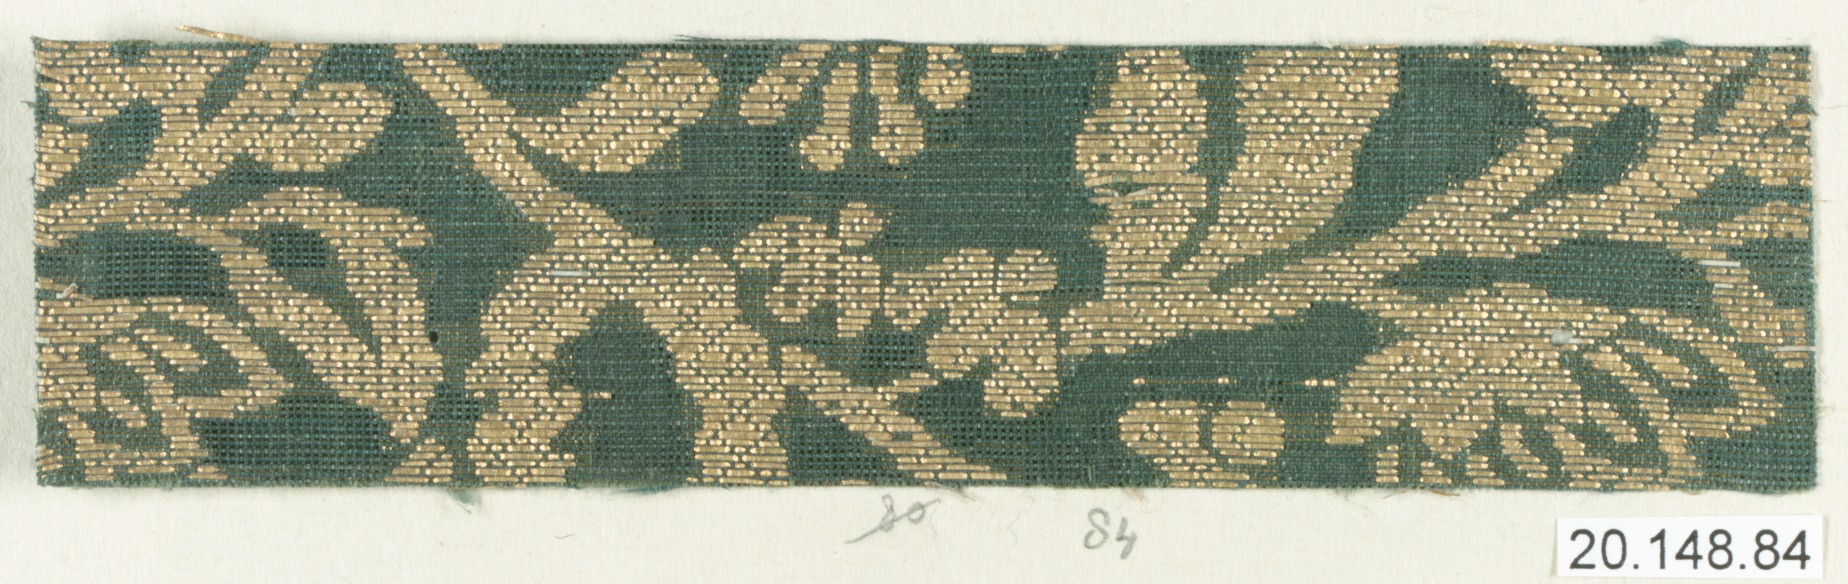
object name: piece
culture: china or japan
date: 1501-1600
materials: silk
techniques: compound weave